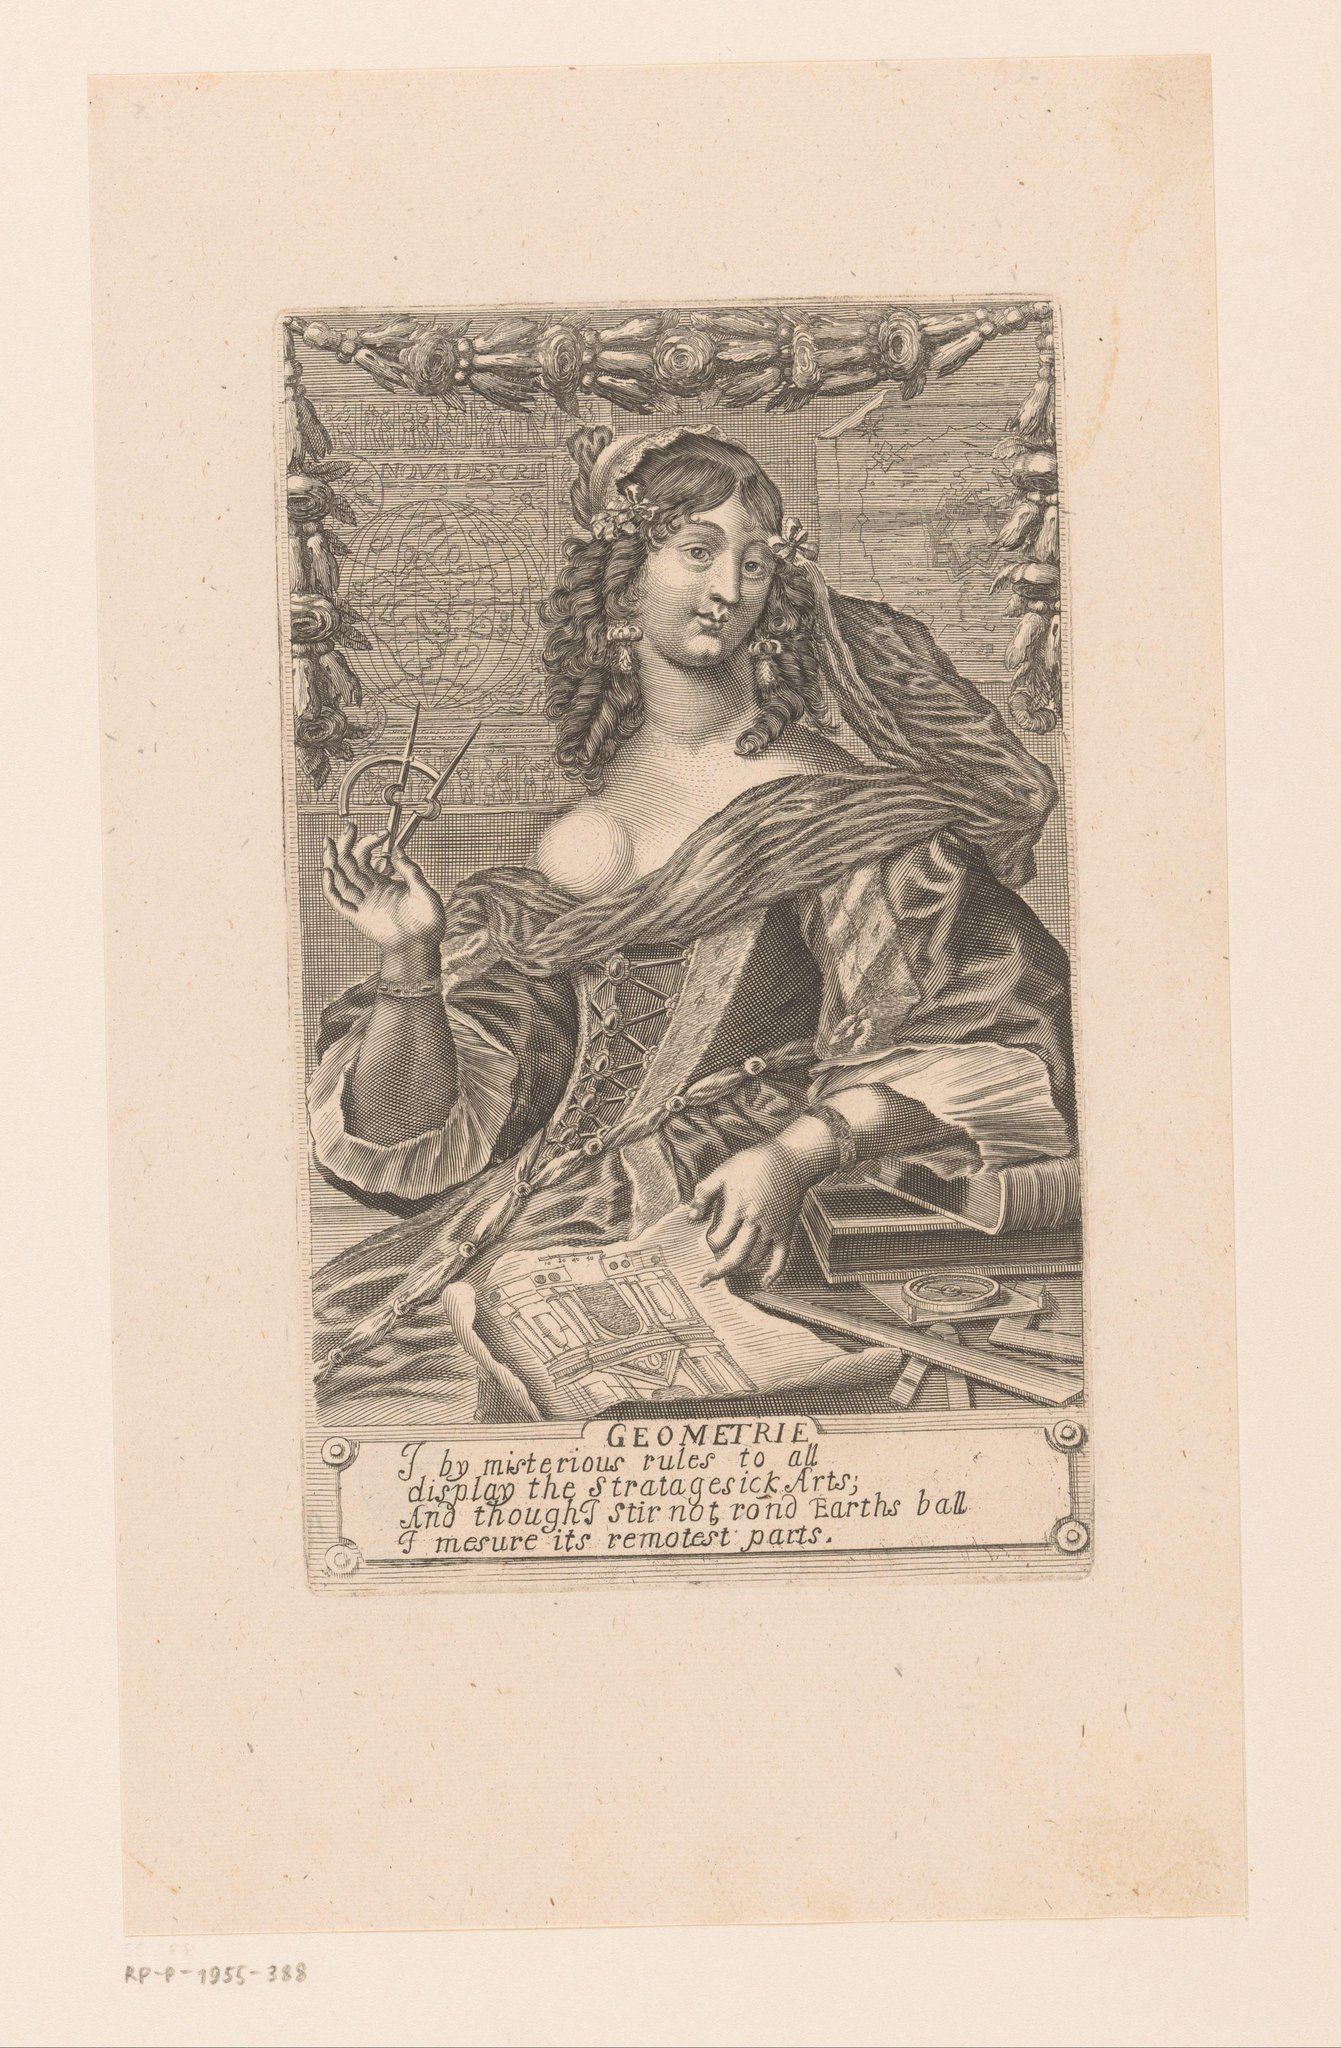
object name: print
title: Minerva en de zeven vrije kunsten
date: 1623-1681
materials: paper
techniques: engraving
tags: 'geometria' (~ quadrivium); 'geometria' (ripa)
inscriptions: collector's mark: Lugt 847a, collector's mark: Lugt 2228, collector's mark: Lugt 919ter